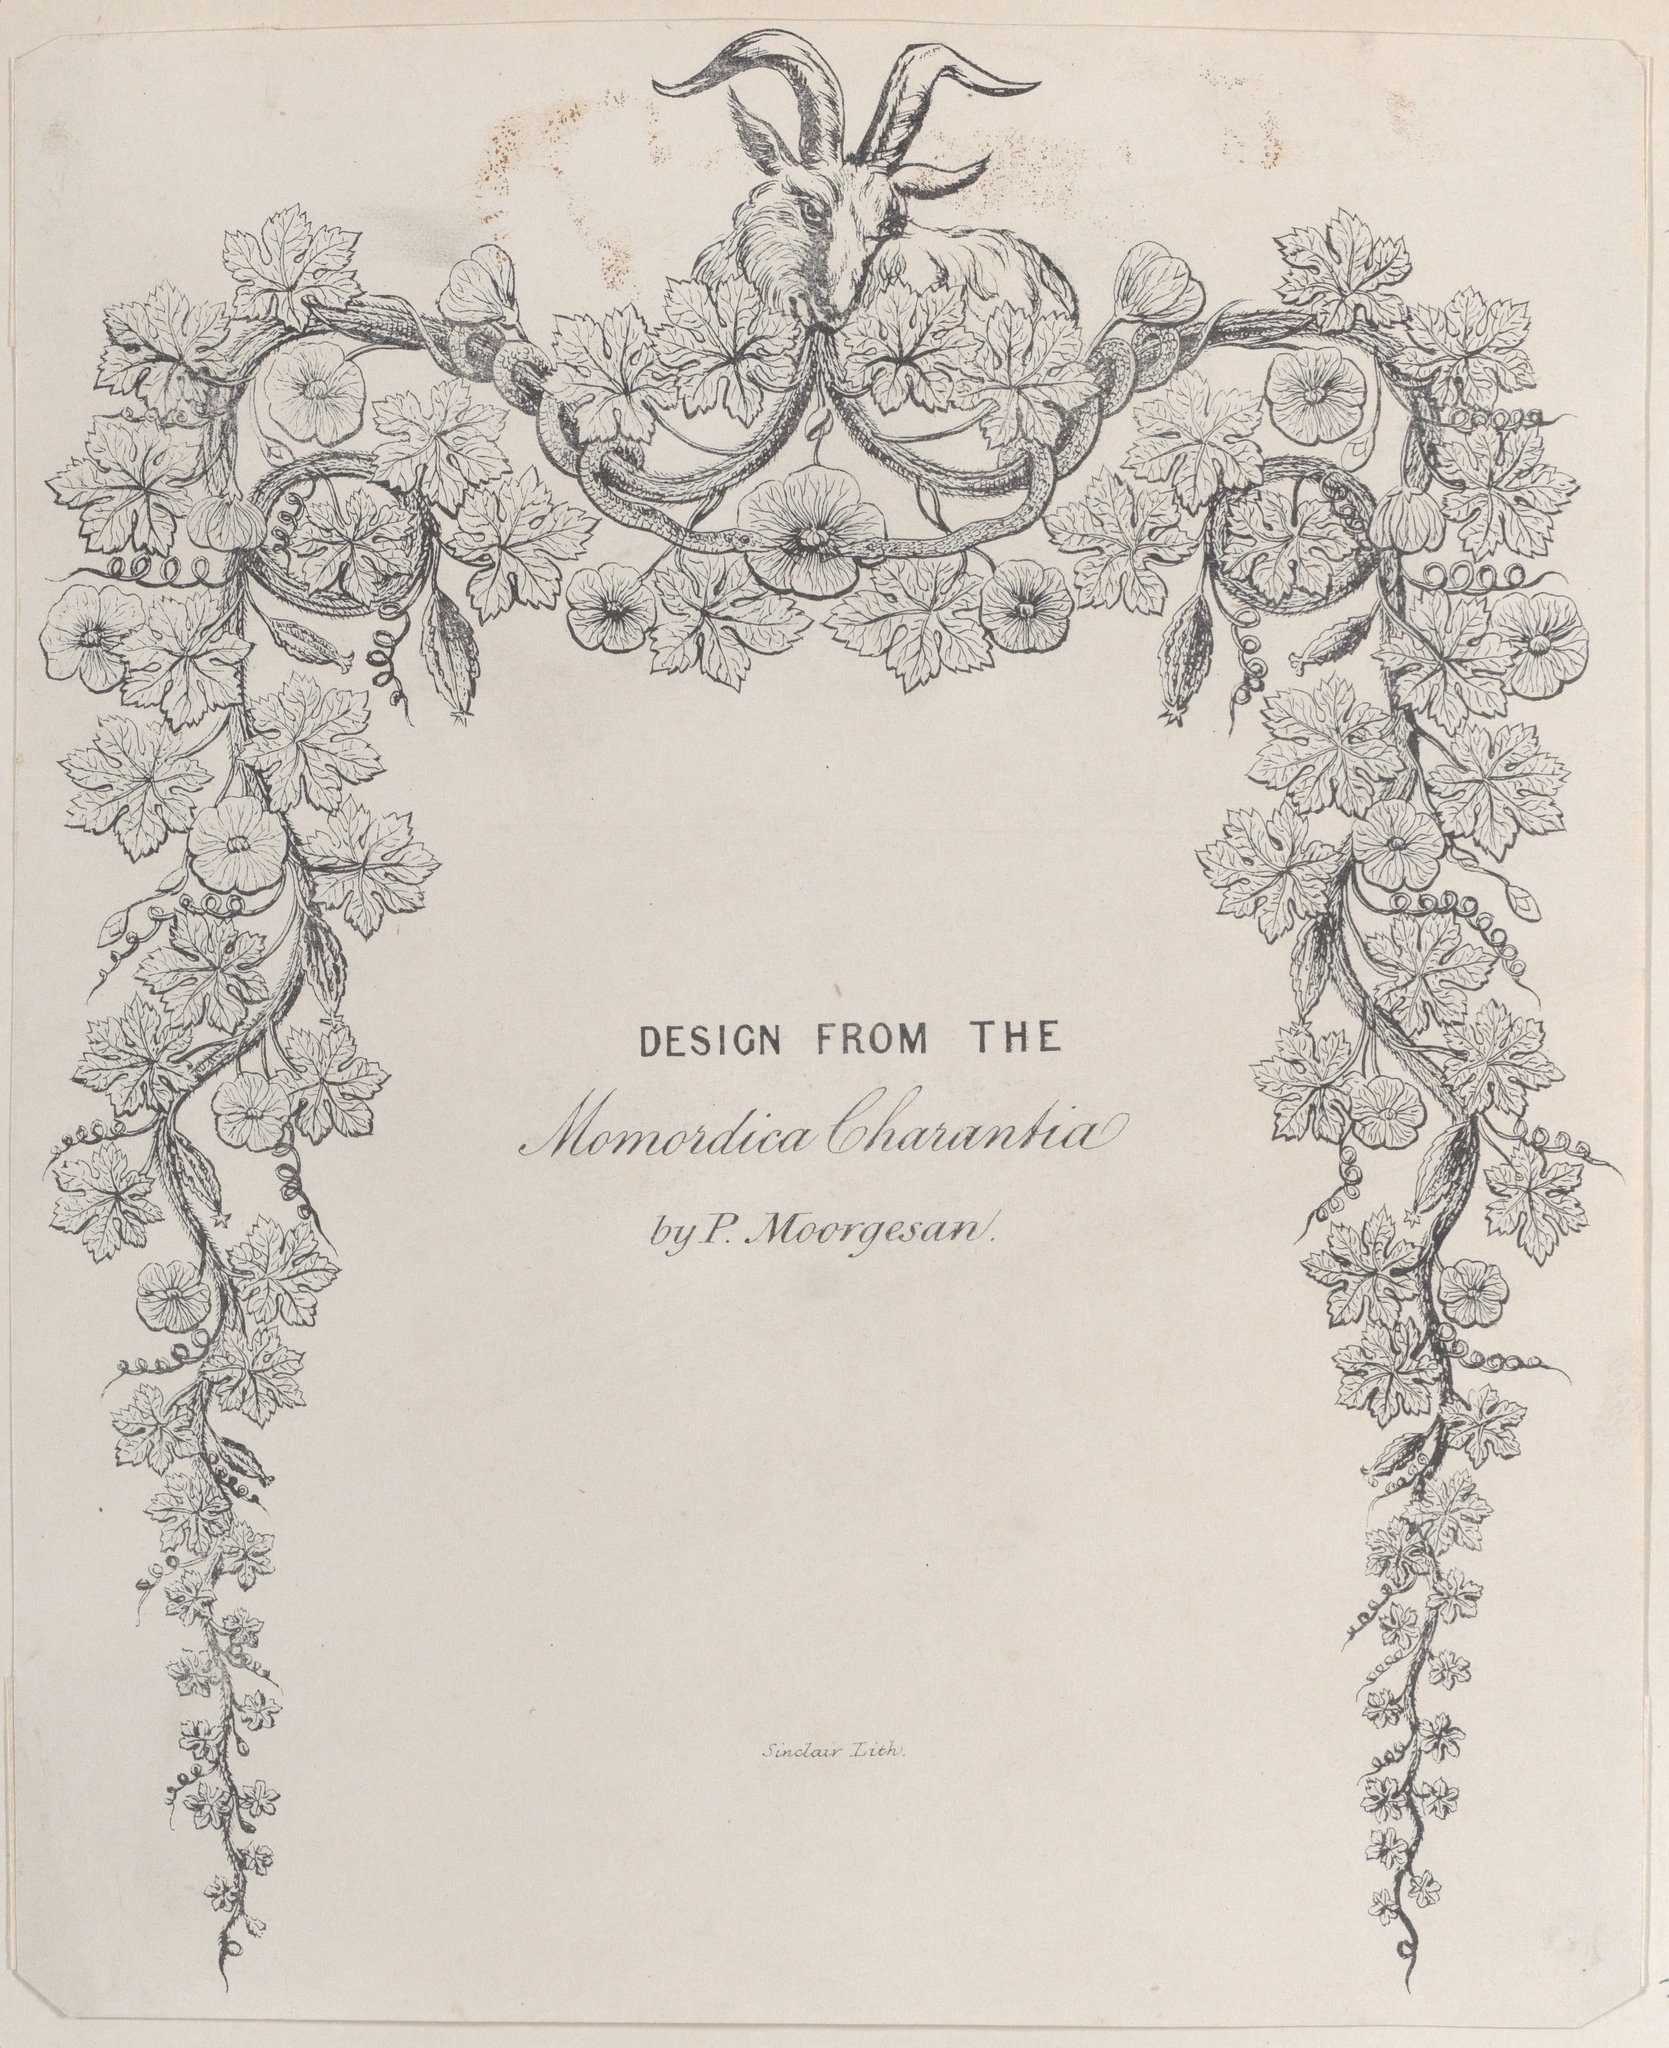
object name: print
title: Design from the Momordica Charantia by P. Moorgesan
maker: anonymous, british, 19th century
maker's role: artist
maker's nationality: british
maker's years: 1800-1900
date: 1801-1900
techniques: lithography